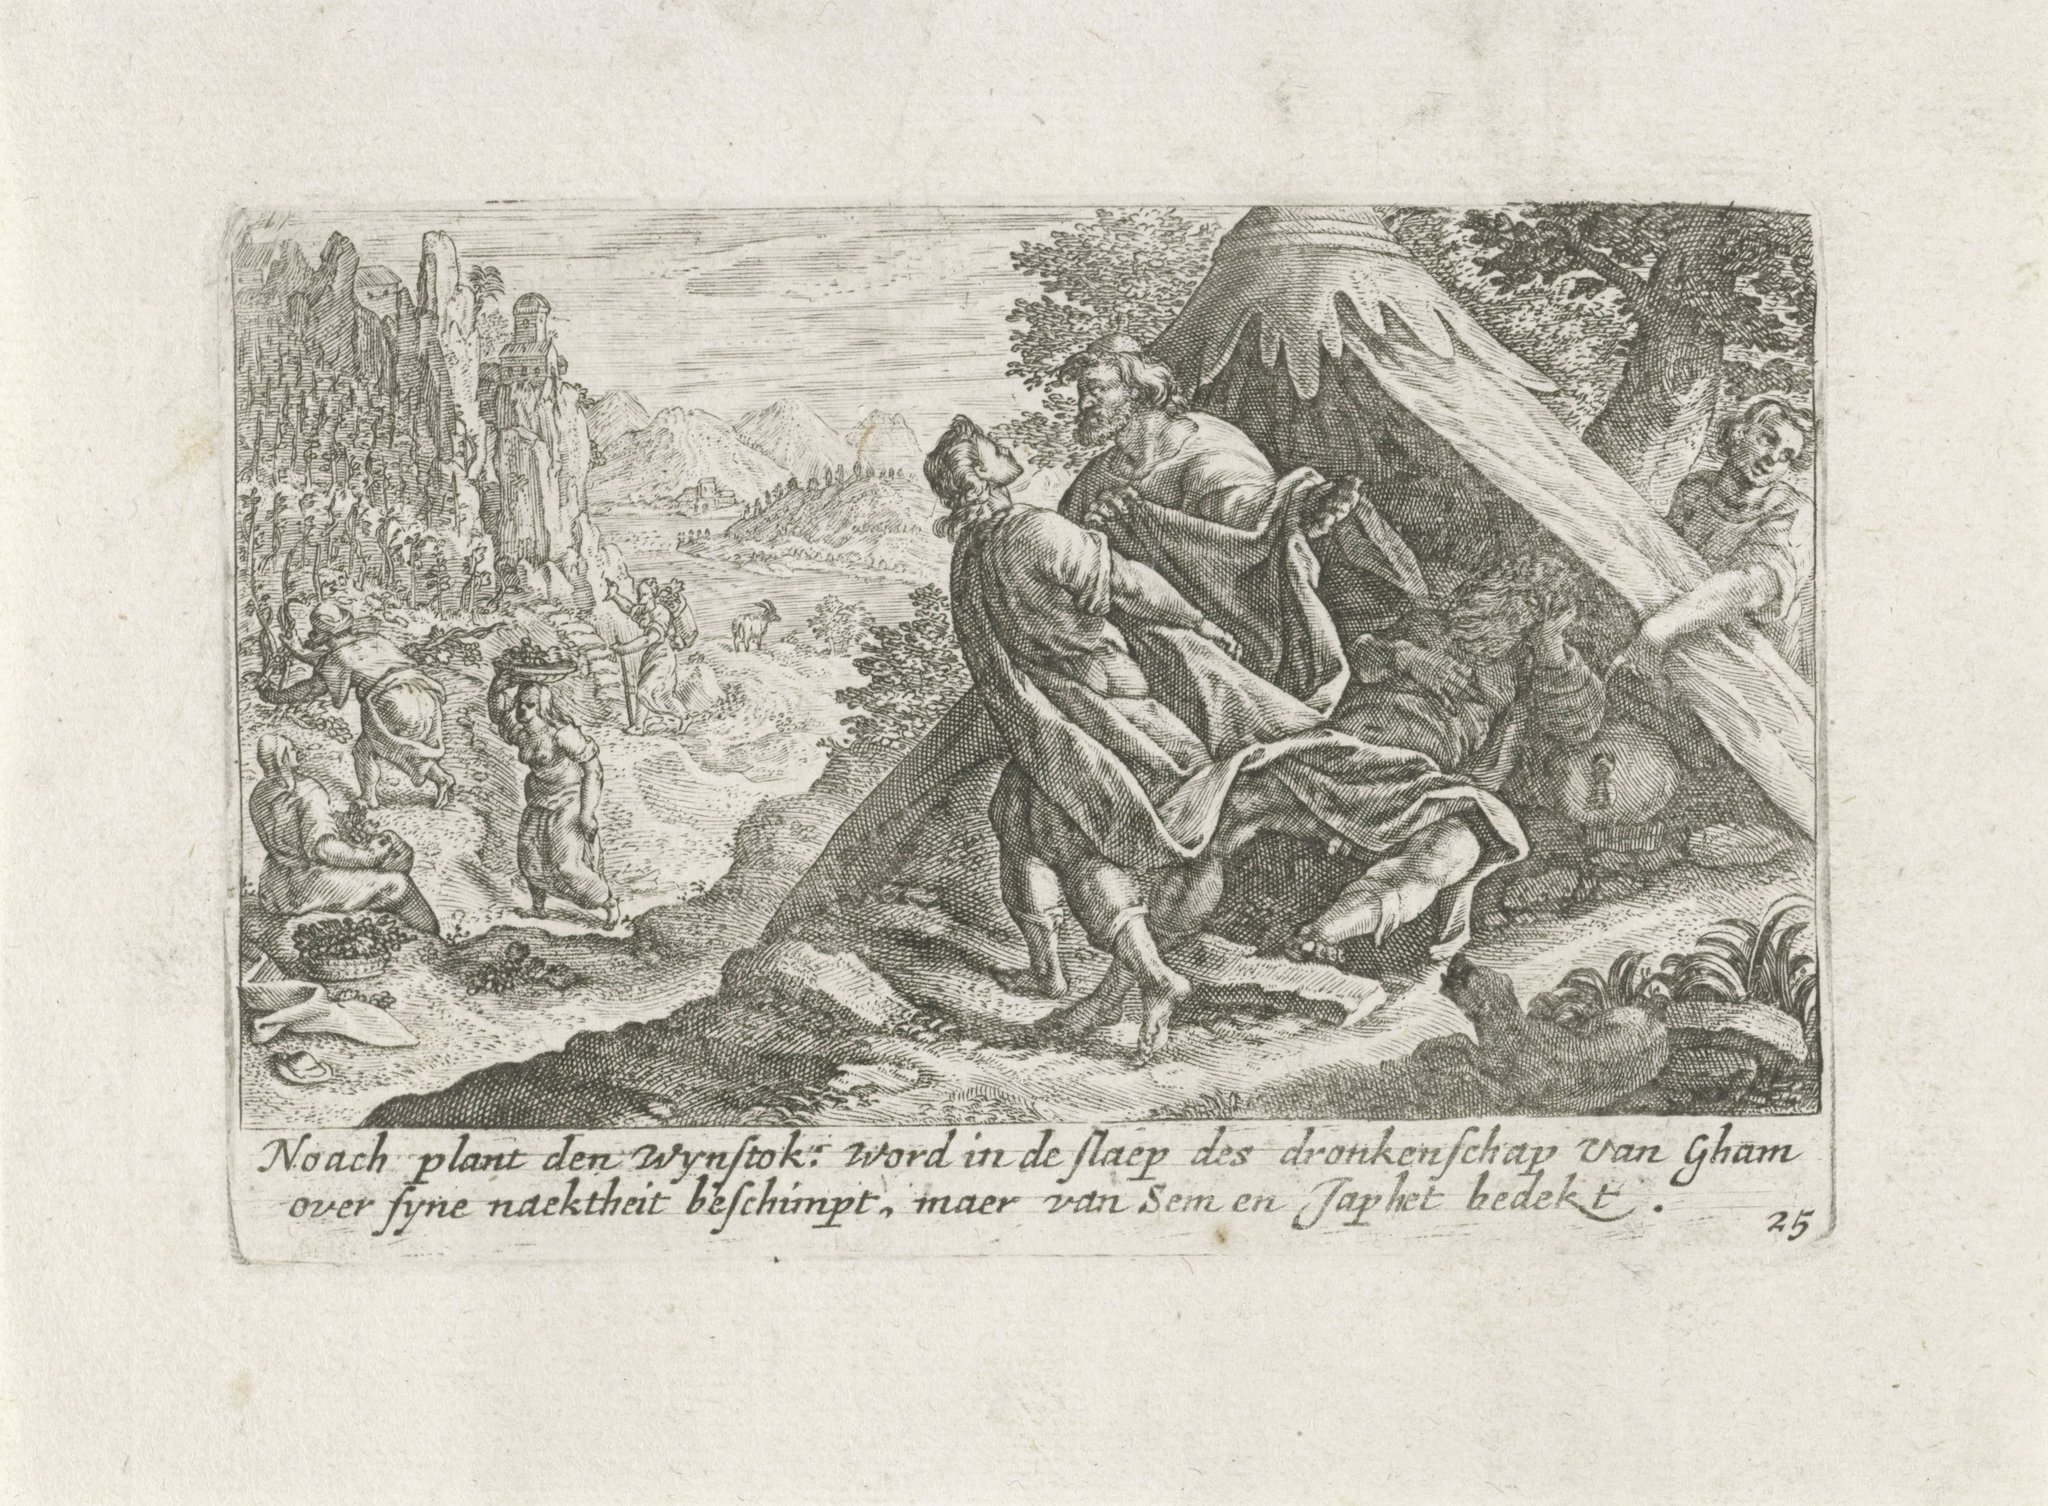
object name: print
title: Liber Genesis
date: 1700-1750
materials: paper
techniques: engraving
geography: utrecht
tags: shem and japheth cover their father noah; ham usually stands nearby deriding him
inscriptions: collector's mark: Lugt 2233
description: Noach ligt dronken en half ontkleed voor zijn tent. Zijn zoon Cham wijst naar hem en bespot hem. Sem en Jafet schermen hun vader af met een kleed. Op de achtergrond de wijngaard van Noach. In de marge een tweeregelig onderschrift in het Nederlands.